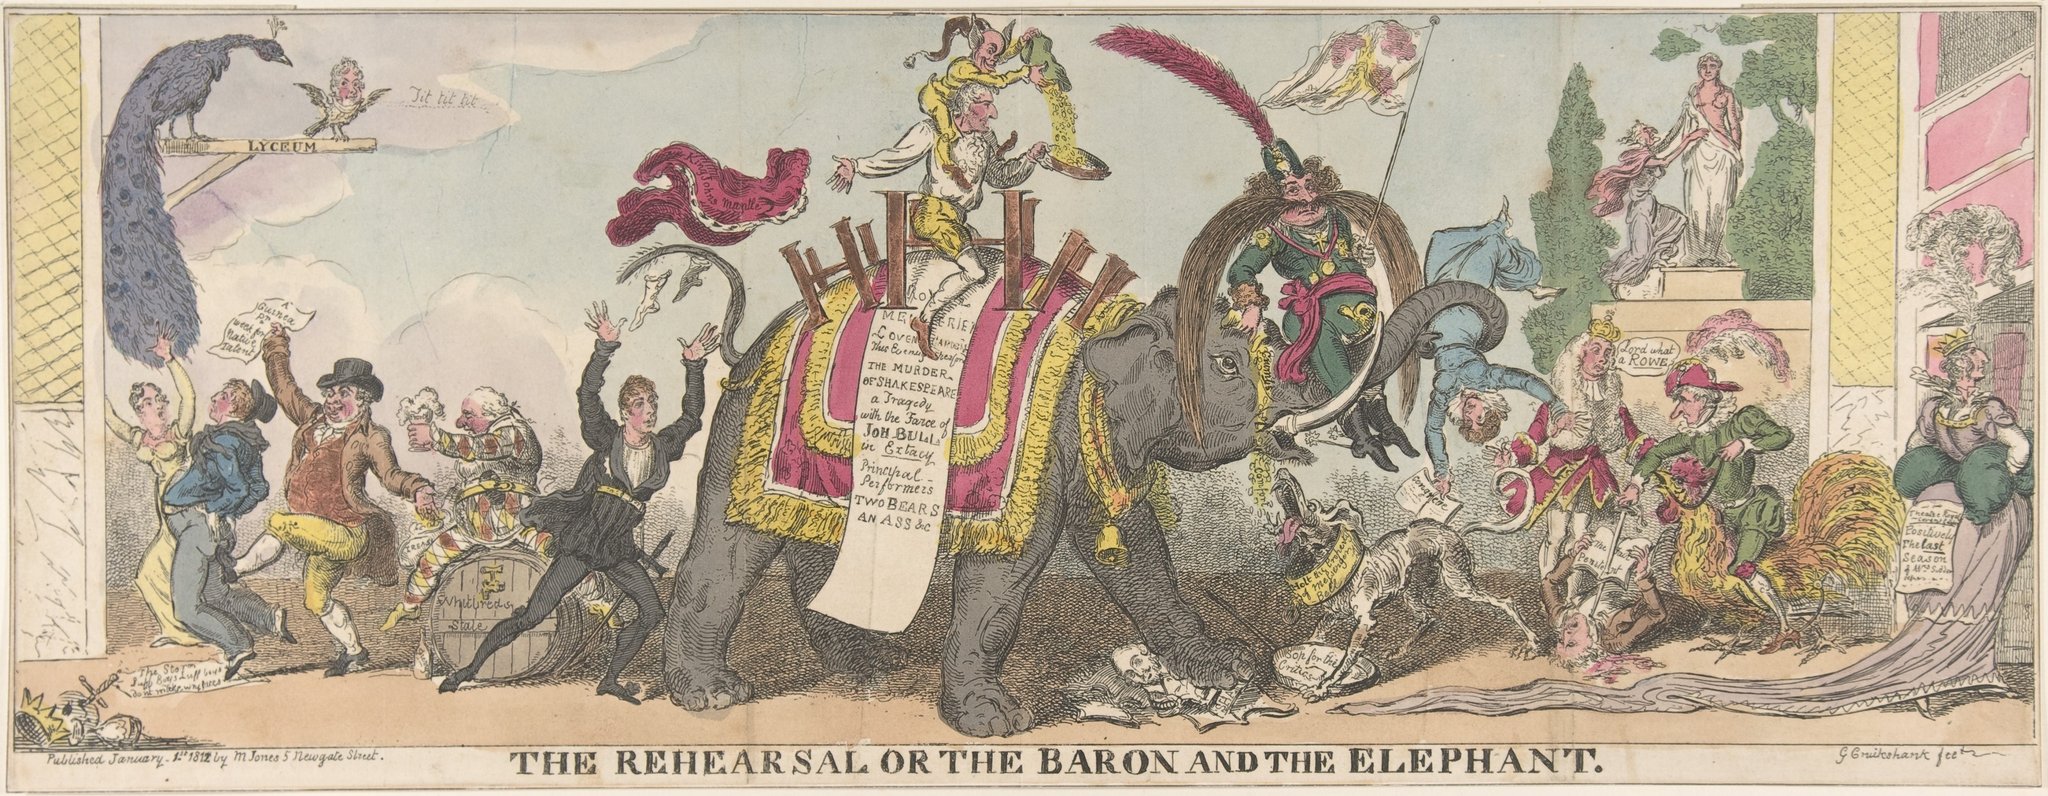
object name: print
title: The Rehearsal or the Baron and the Elephant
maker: george cruikshank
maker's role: artist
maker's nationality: british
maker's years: 1792-1878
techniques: etching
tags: performance,men,women,peacocks,elephants